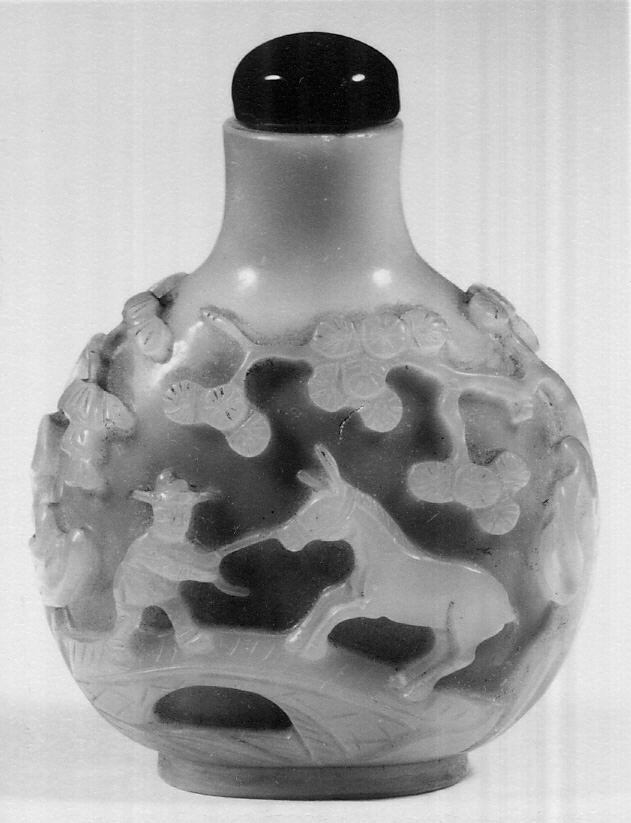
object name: snuff bottle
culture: chinese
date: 1801-1900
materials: glass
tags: men,donkeys